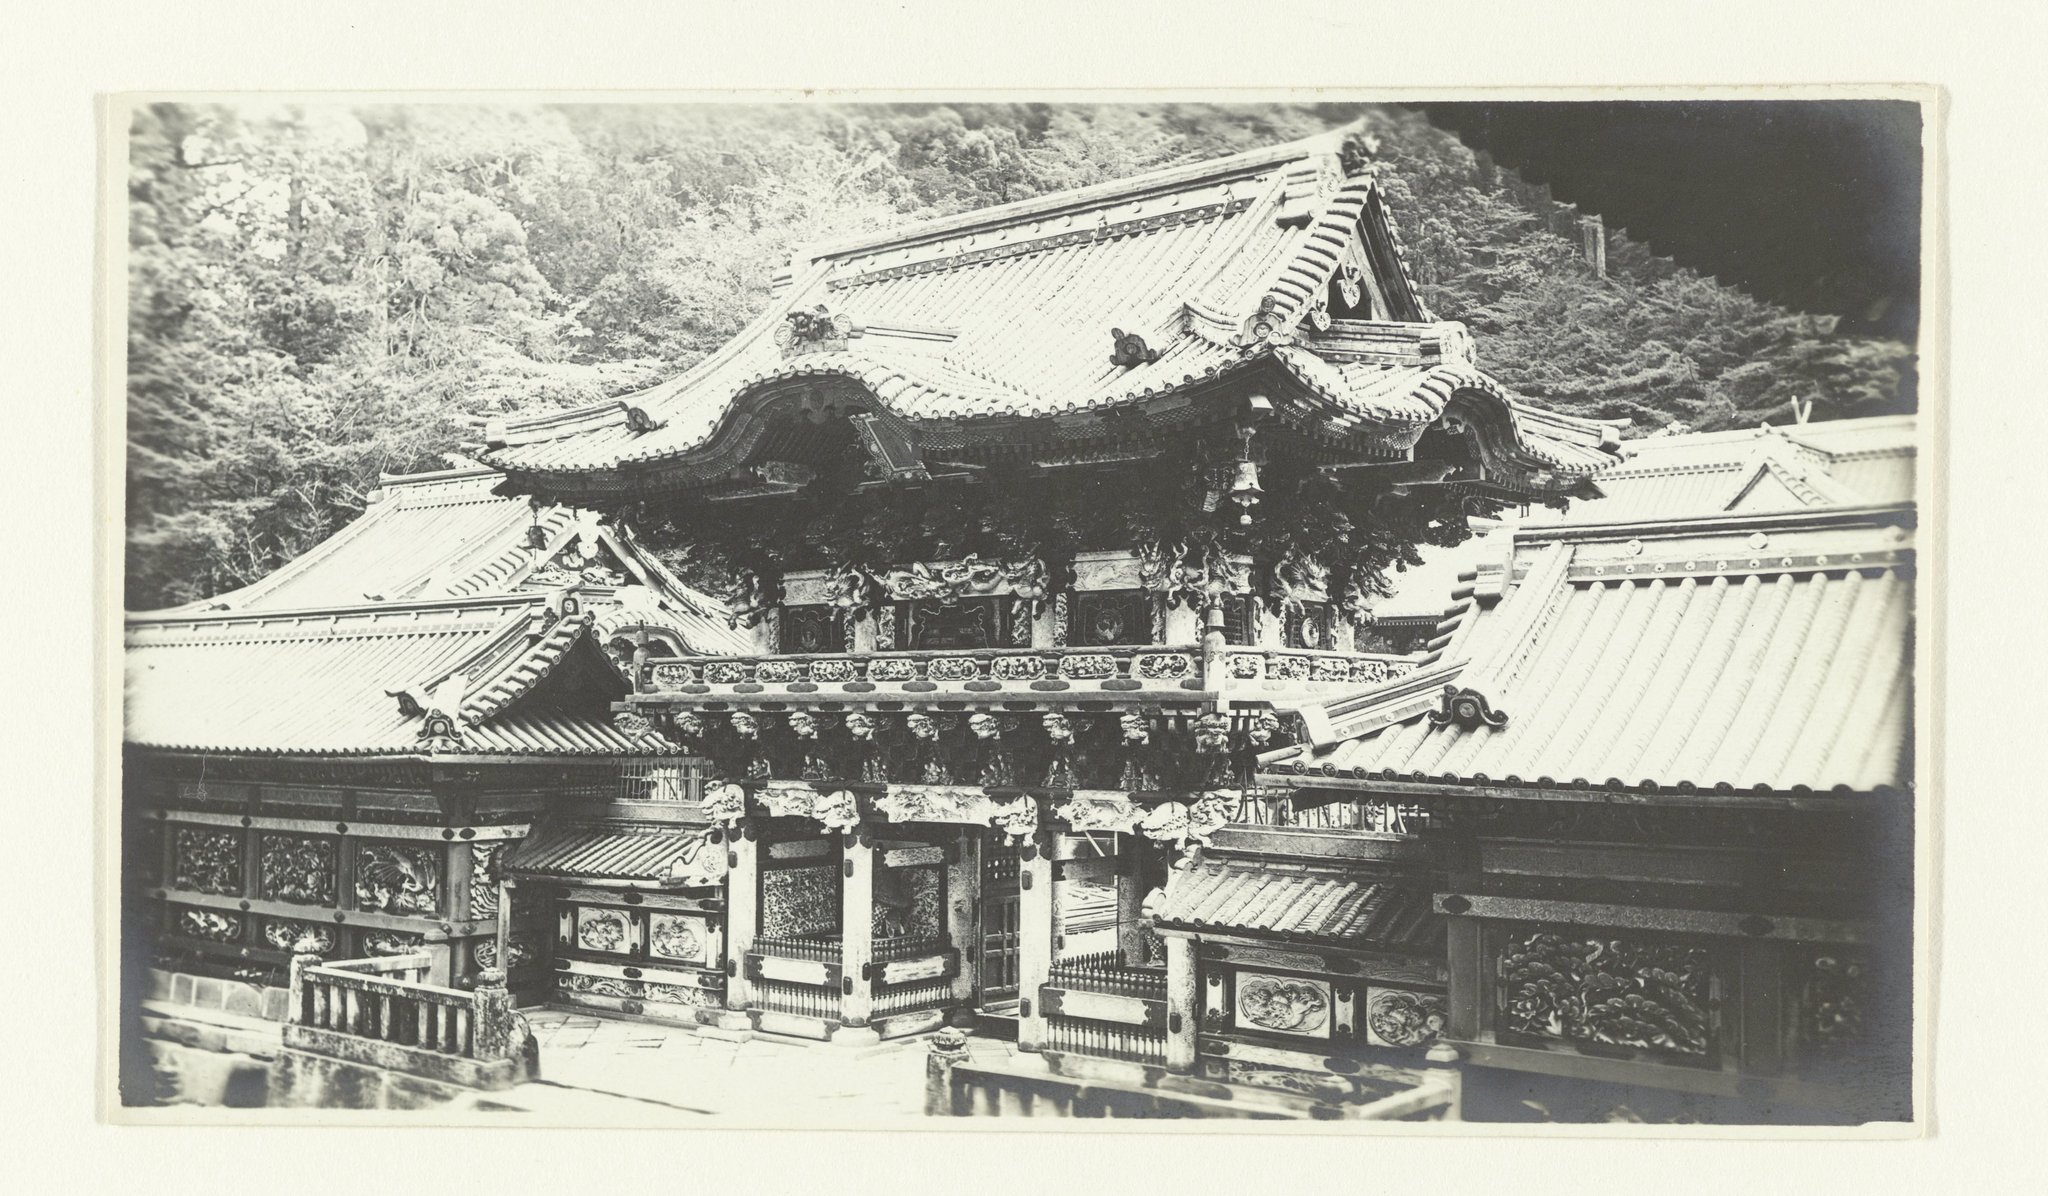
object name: photograph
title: Toegangspoort (Yomeinon poort) van het Toshogu heiligdom, Nikko, Japan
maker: jan adriani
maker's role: fotograaf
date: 1907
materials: paper, photographic support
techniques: gelatin silver print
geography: japan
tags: temple, shrine ~ non-christian religions